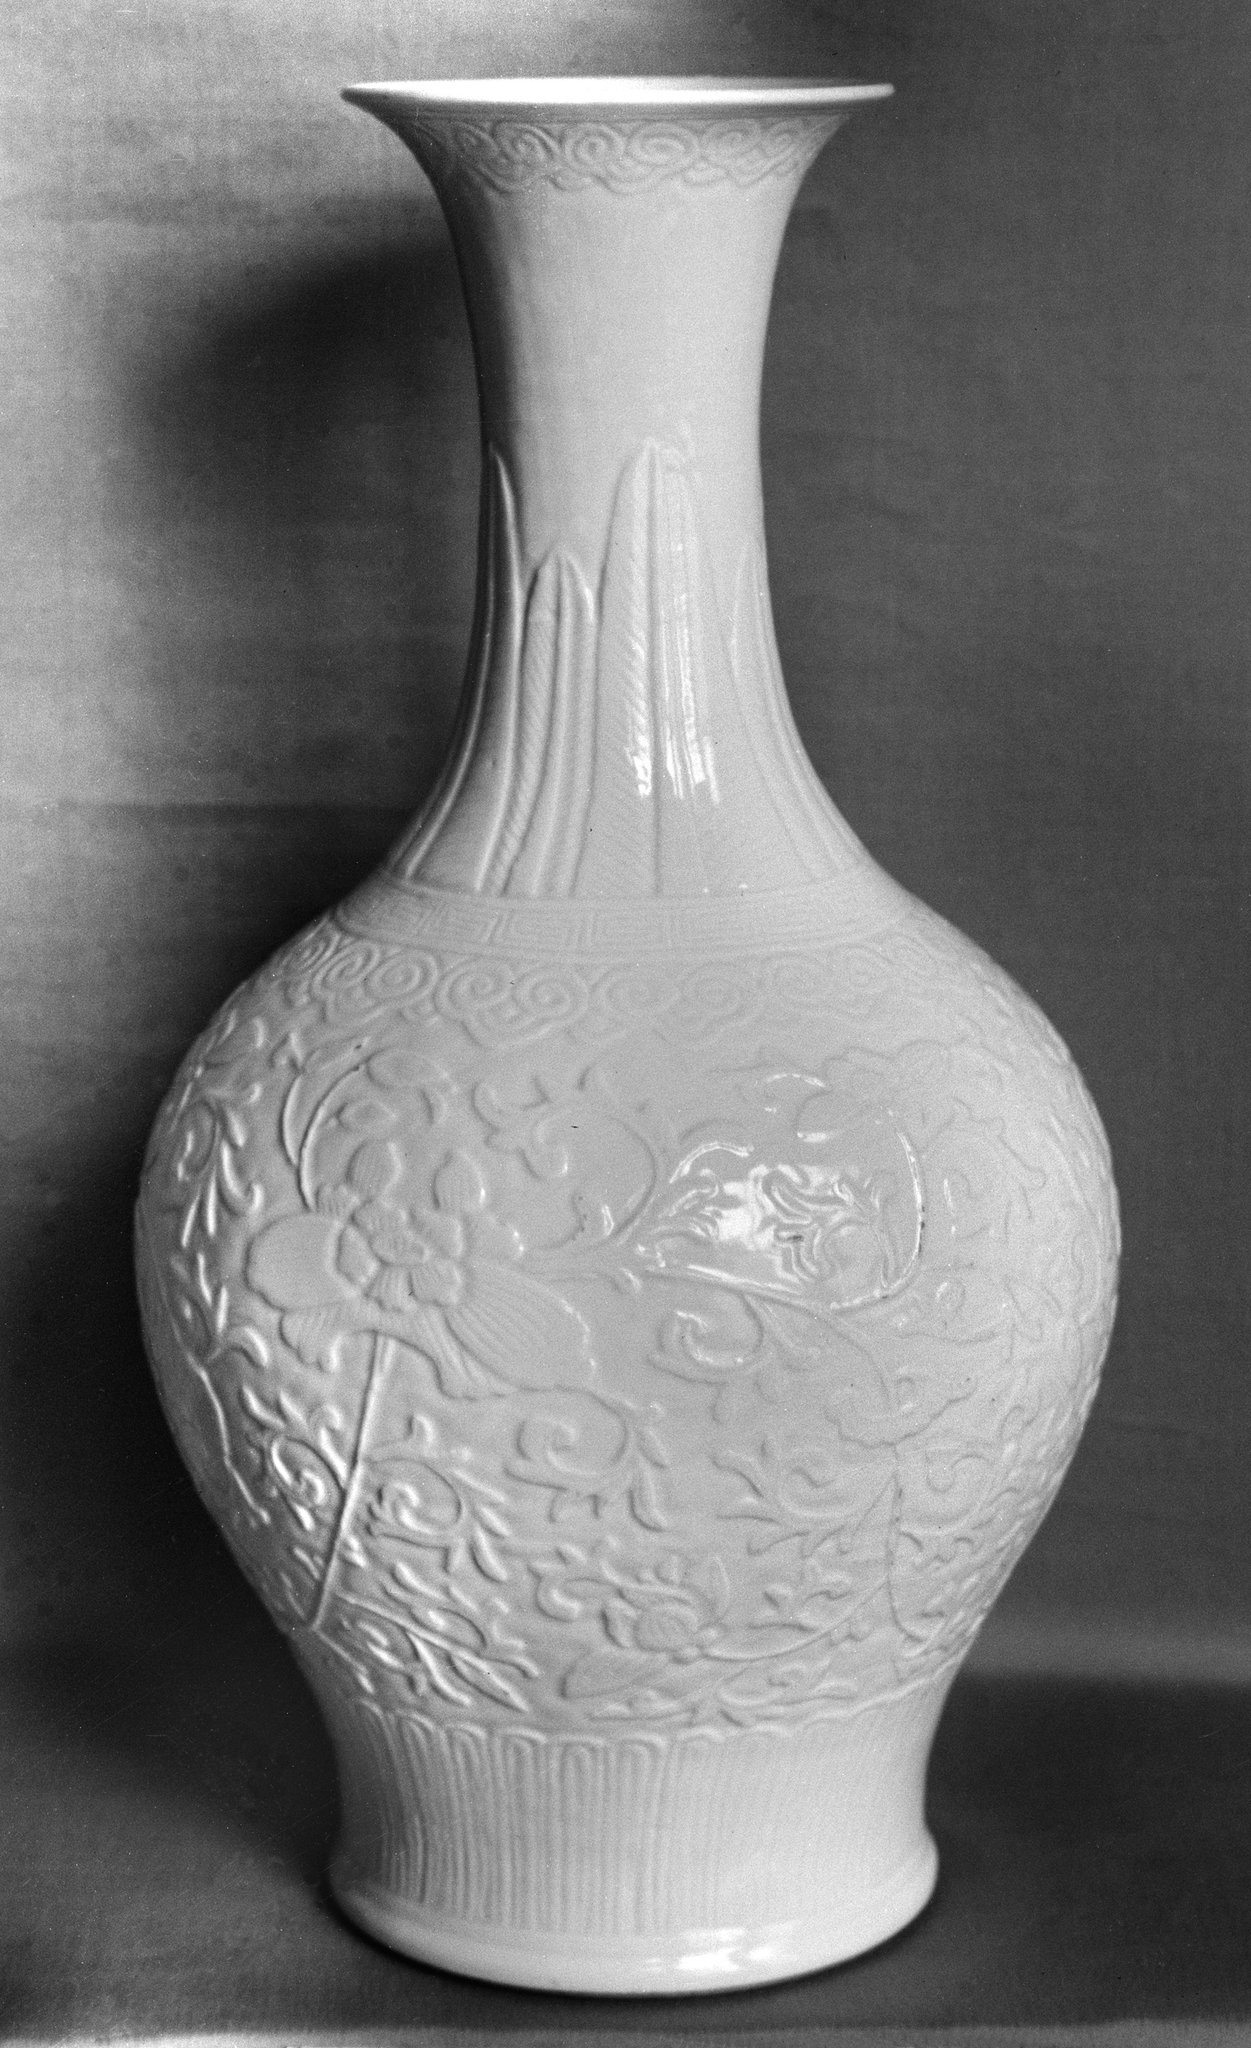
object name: bottle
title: Bottle with flowers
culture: chinese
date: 1801-1900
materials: porcelain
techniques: molding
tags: flowers,leaves